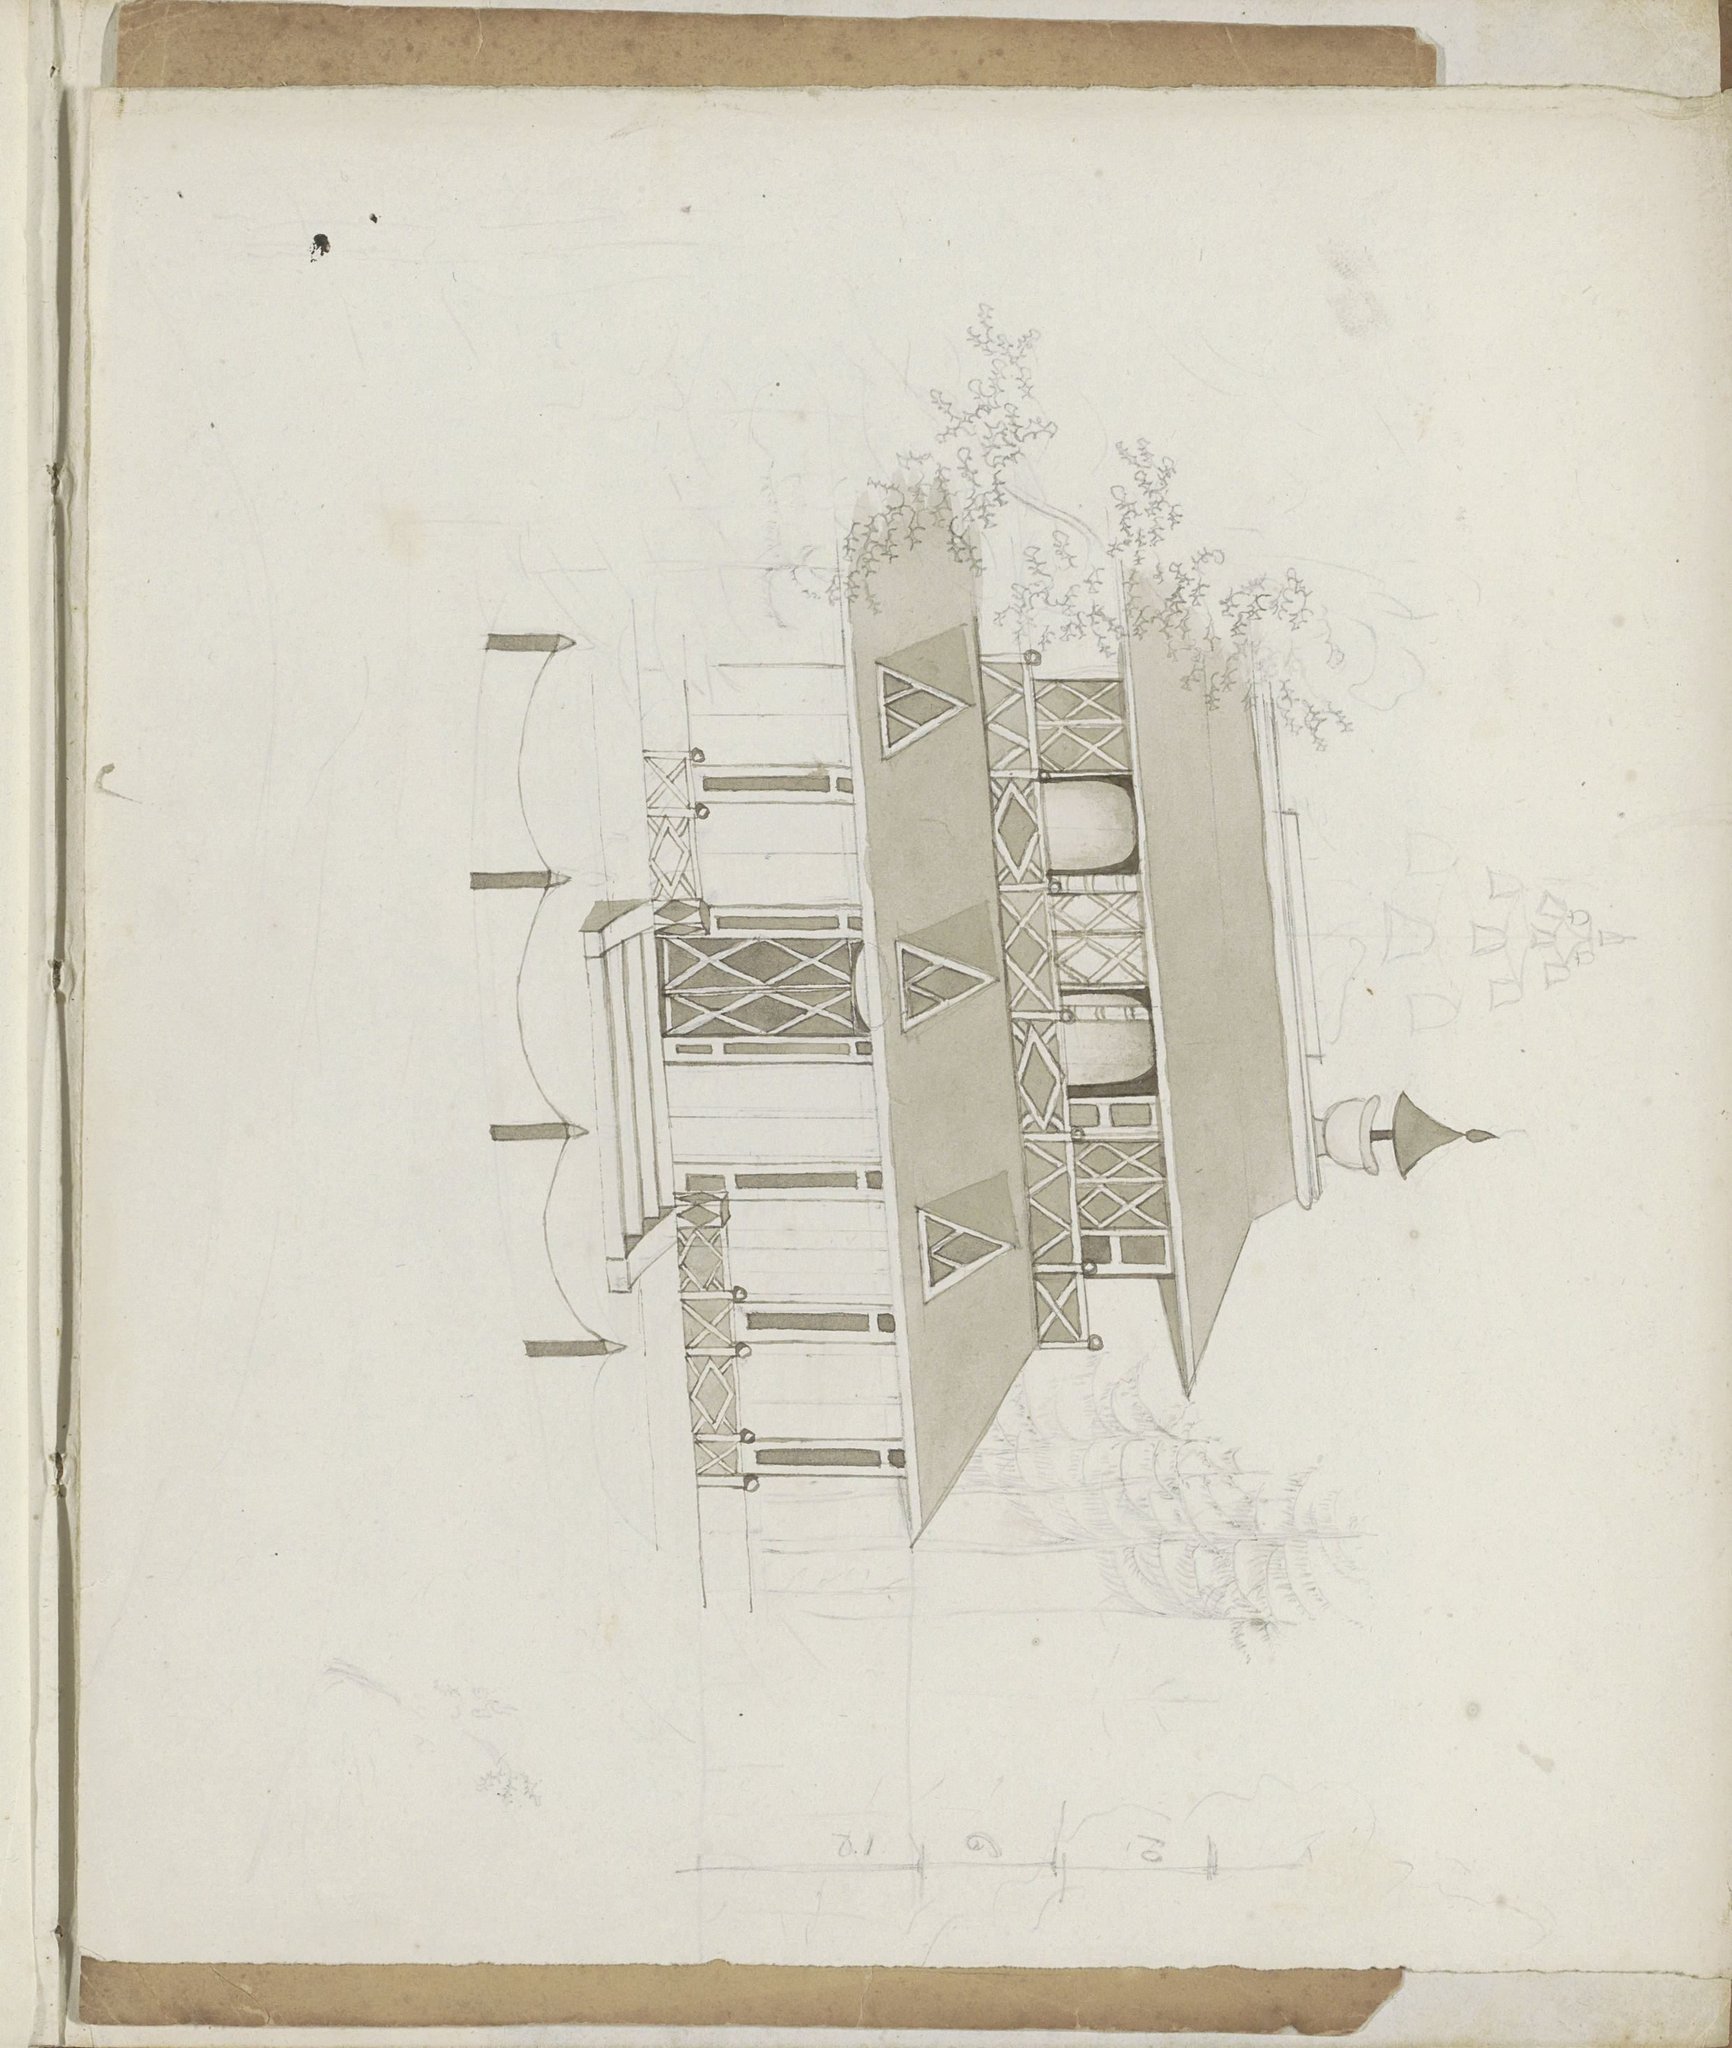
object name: sketchbook leaf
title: Huis Peking te Baarn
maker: jonkvrouw elisabeth kemper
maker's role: draughtsman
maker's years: 1799-1871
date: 1815-1852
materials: ink, paper, pencil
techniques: pen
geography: baarn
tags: country-house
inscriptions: annotation: ‘huis Peking te Baarn’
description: Recto van een losse tekening tussen blad 94 en het achterste schutblad uit een schetsboek met 94 bladen.